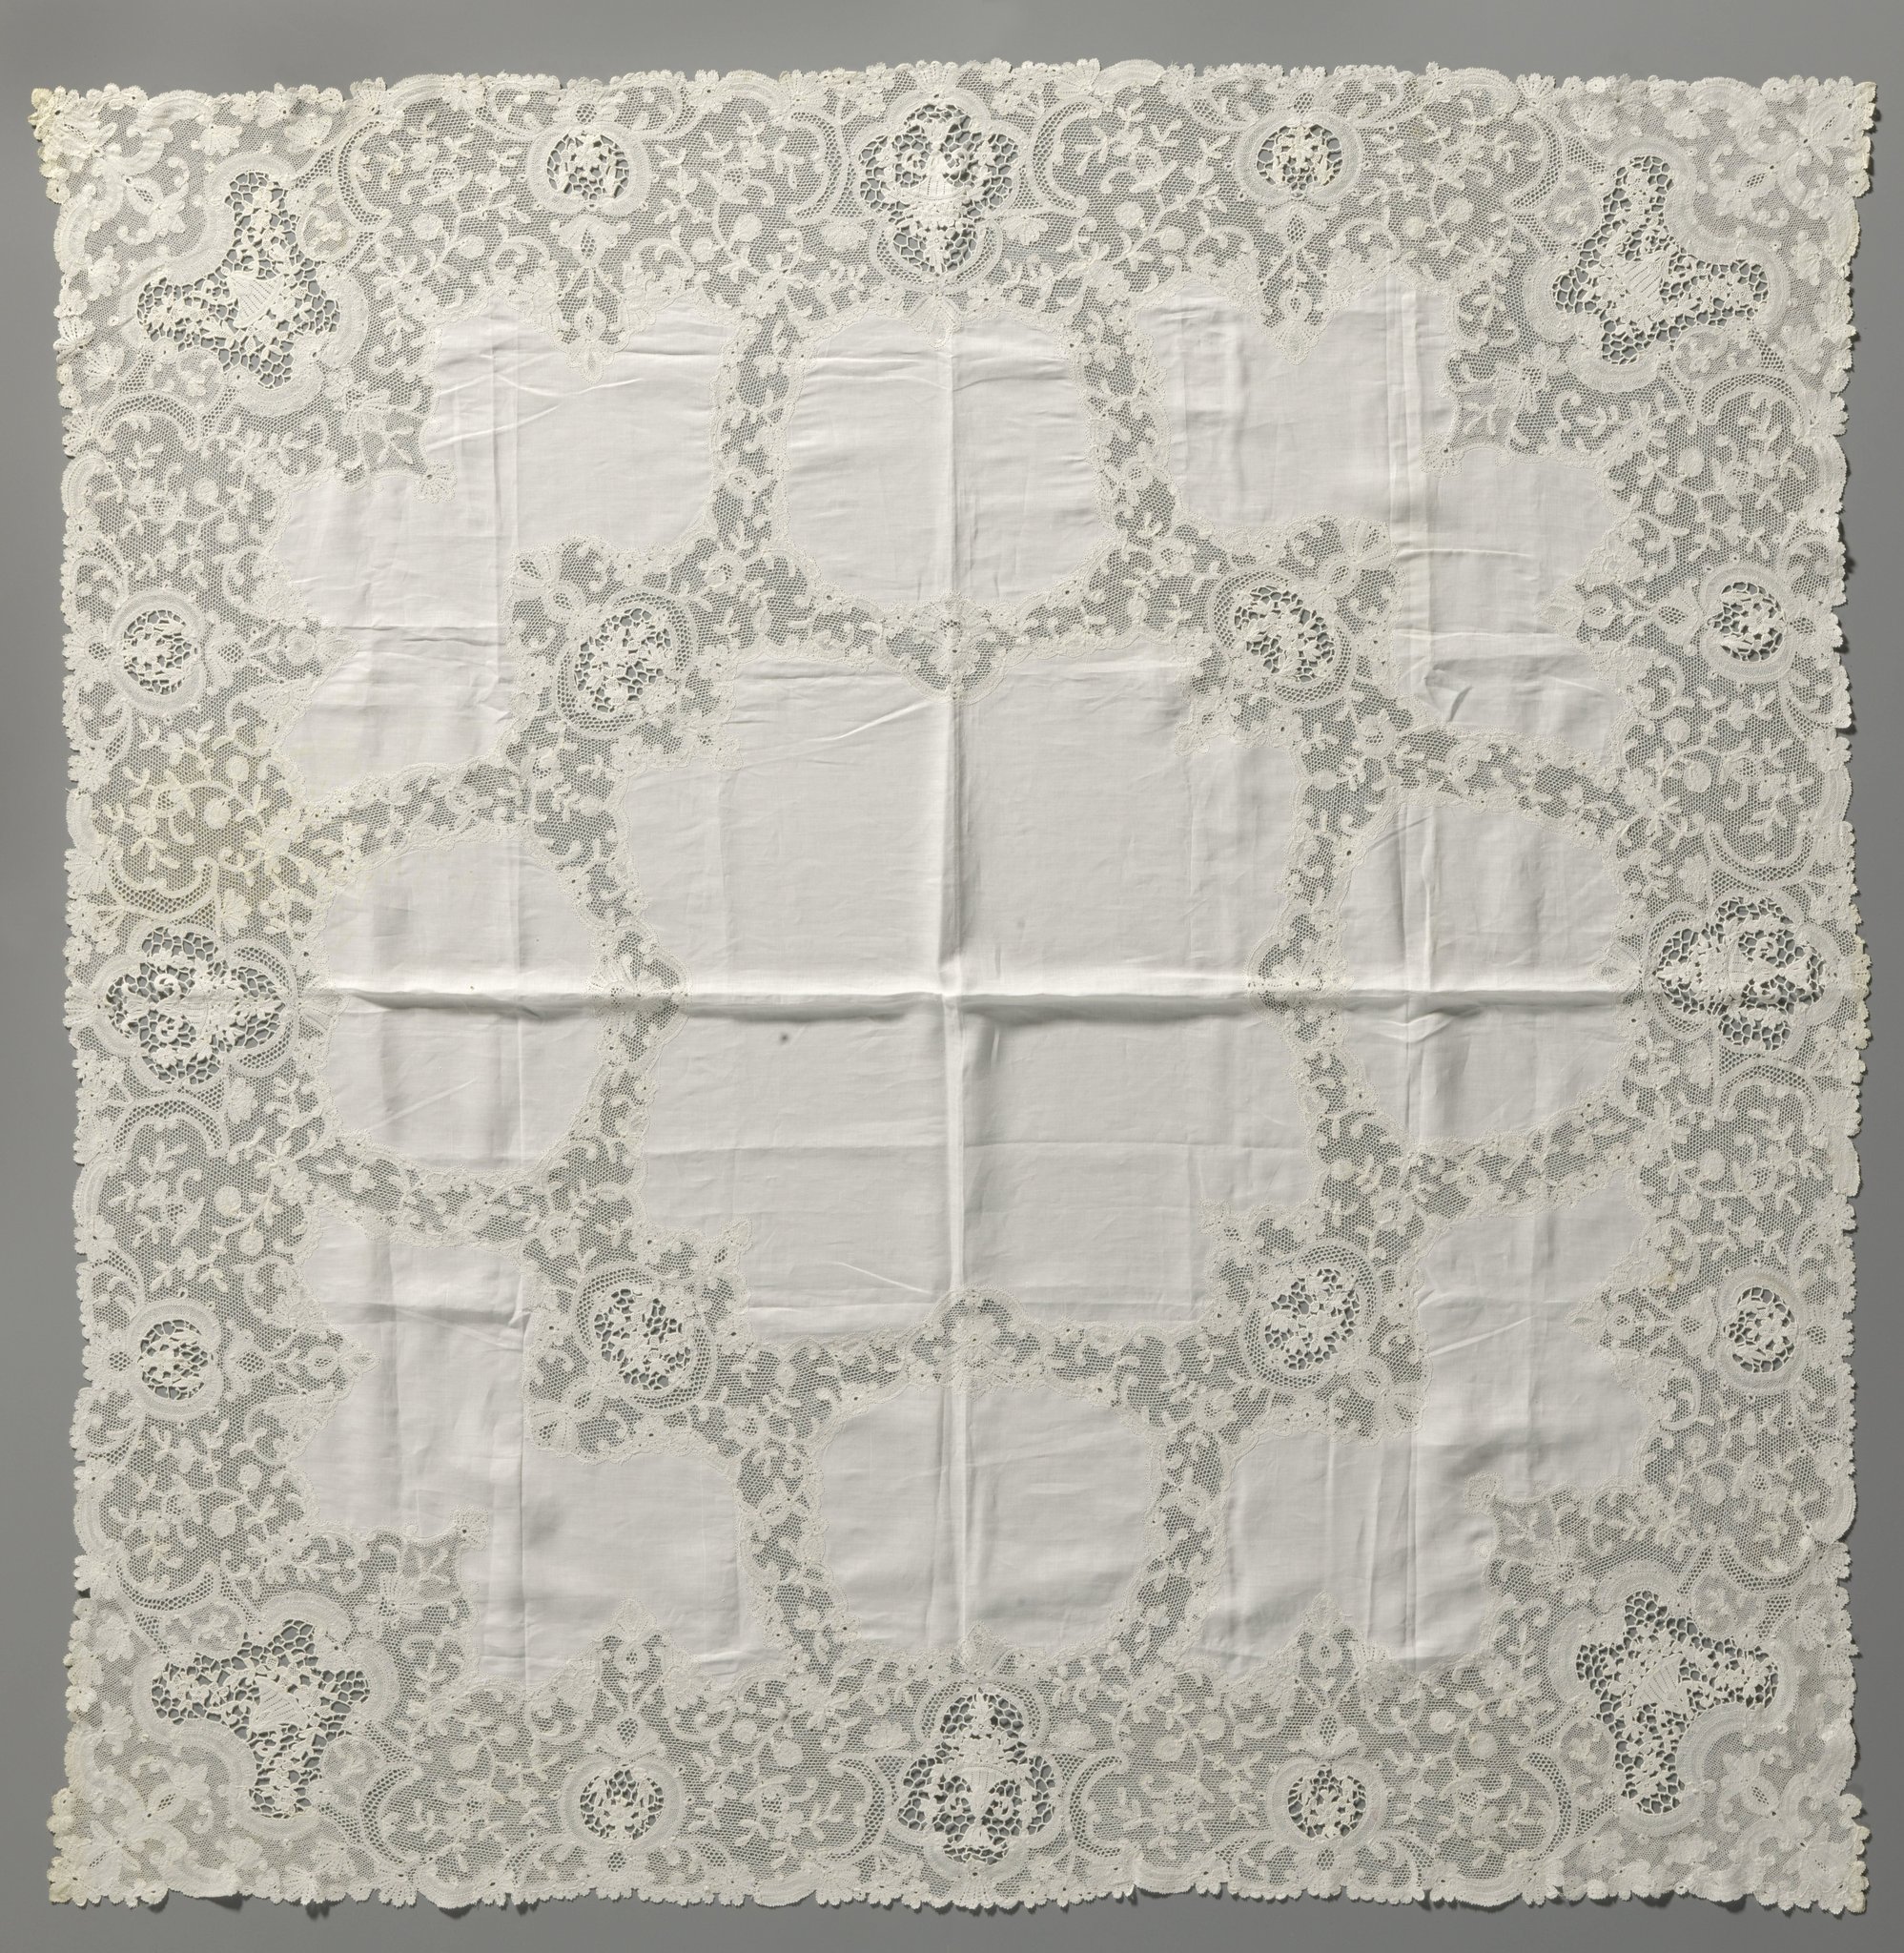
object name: tafelkleed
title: Tafelkleed van batist en gemengde kant met cartouches en bloemvazen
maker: Anonymous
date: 1925-1929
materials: linen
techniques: lace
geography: brussels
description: Tafelkleed van batist en naturelkleurige gemengde kant, kloskant en naaldkant. Rechthoekig model met in het midden een stuk batist met daar omheen acht kleinere stukken batist. De stukken in de hoeken zijn palmetvormig, met vier palmetten en de stukken tussen de hoeken zijn licht trapeziumvormig met afgeronde hoeken. De stukken zijn met elkaar verbonden door tussenzetstels van kant, die uitlopen in een brede rand kant met schulpen, waarmee het tafelkleed rondom is afgewerkt. Het kant heeft over het geheel gezien een symmetrisch patroon met bloemenranken, c-voluten, bloemenvazen en cartouches van kloskant. In de cartouches zijn in naaldkant patronen gemaakt met rozetbloemen en bladeren al dan niet in combinatie met bloemenvazen. De motieven in het kloskant zijn met elkaar verbonden door een maasgrond met rechthoekige mazen. De naaldkantmotieven zijn met elkaar verbonden door een gepicoteerde spijlengrond, voornamelijk met onregelmatige vijf- en zeshoeken.